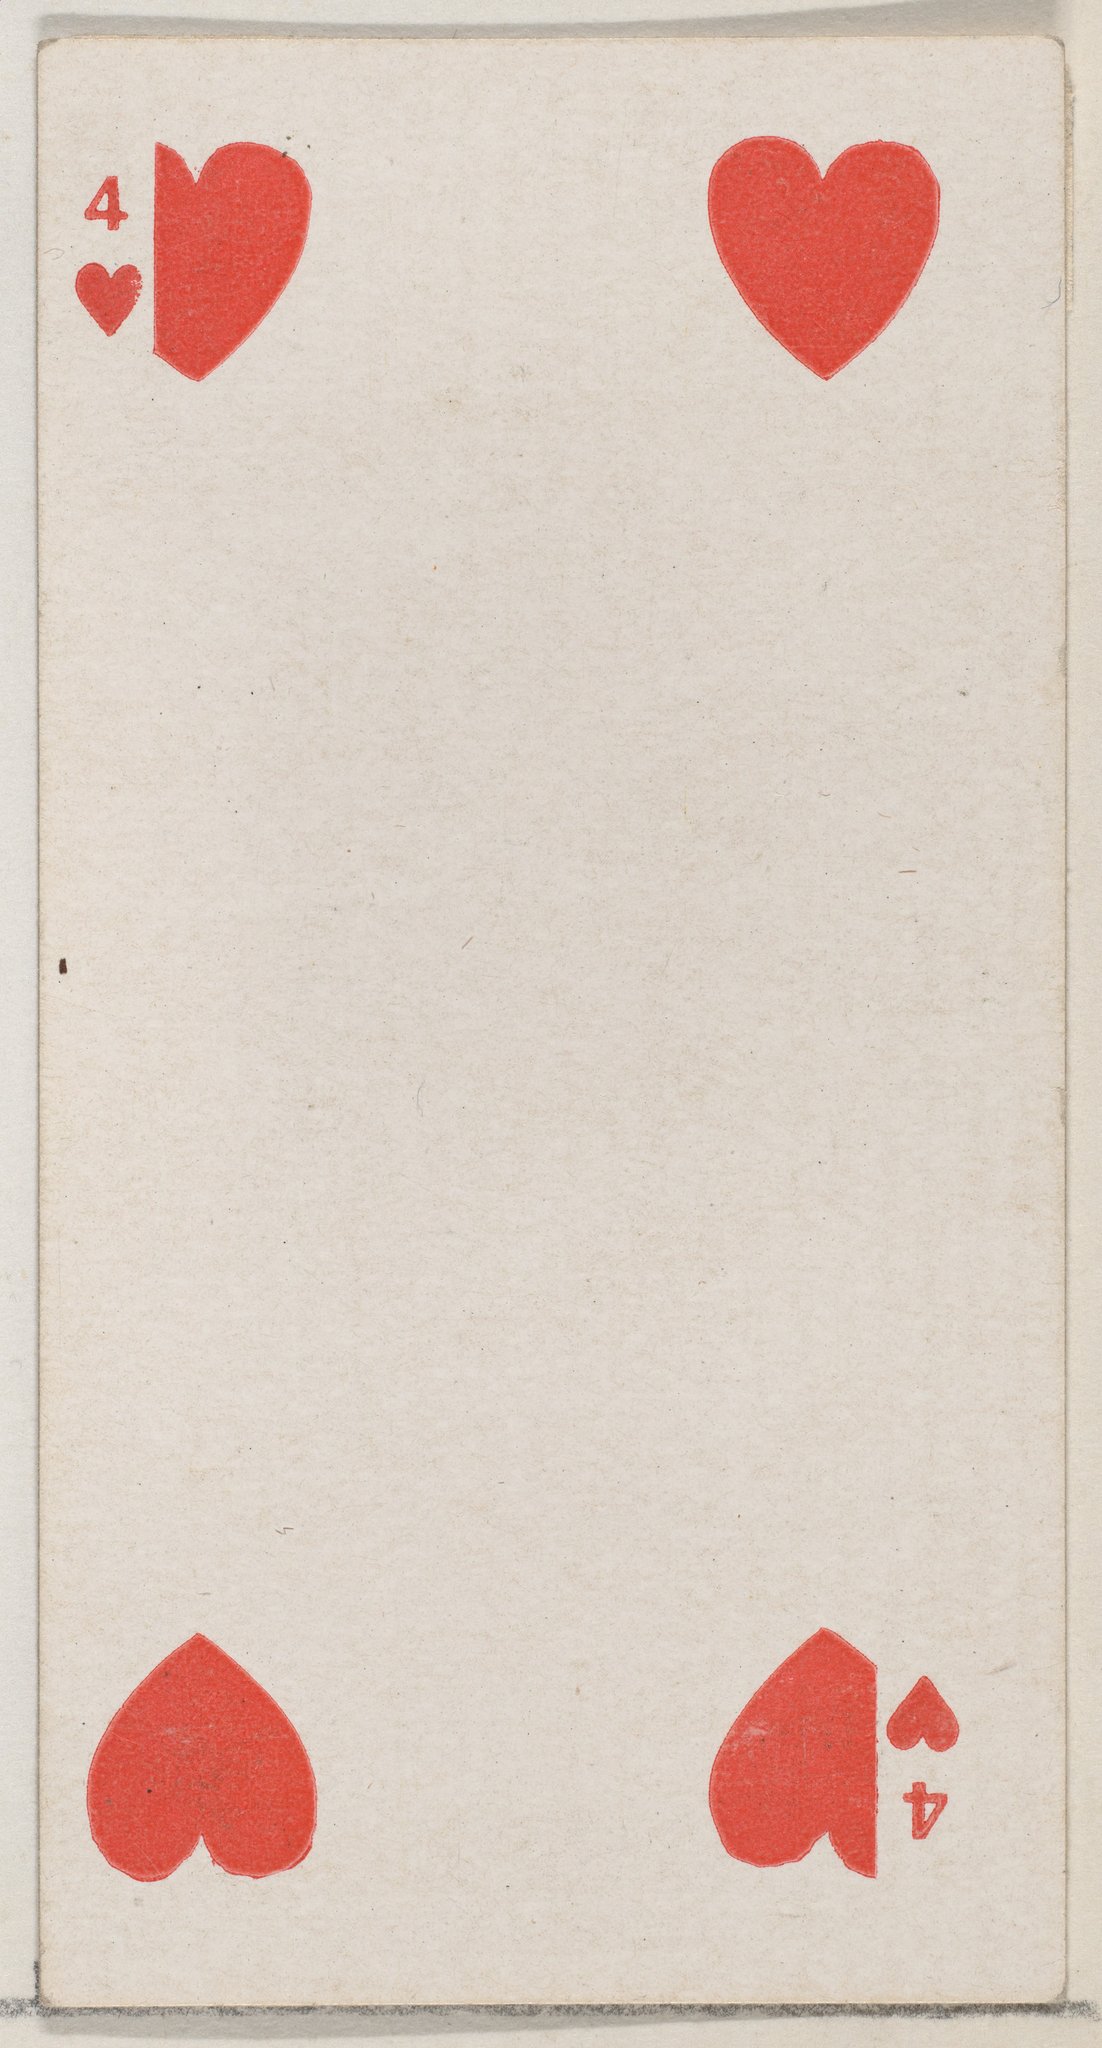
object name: print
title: Four Hearts (red), from the Playing Cards series (N84) for Duke brand cigarettes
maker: w. duke, sons & co.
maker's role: publisher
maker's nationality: american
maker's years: 1870-1920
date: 1888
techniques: color lithograph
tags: playing cards